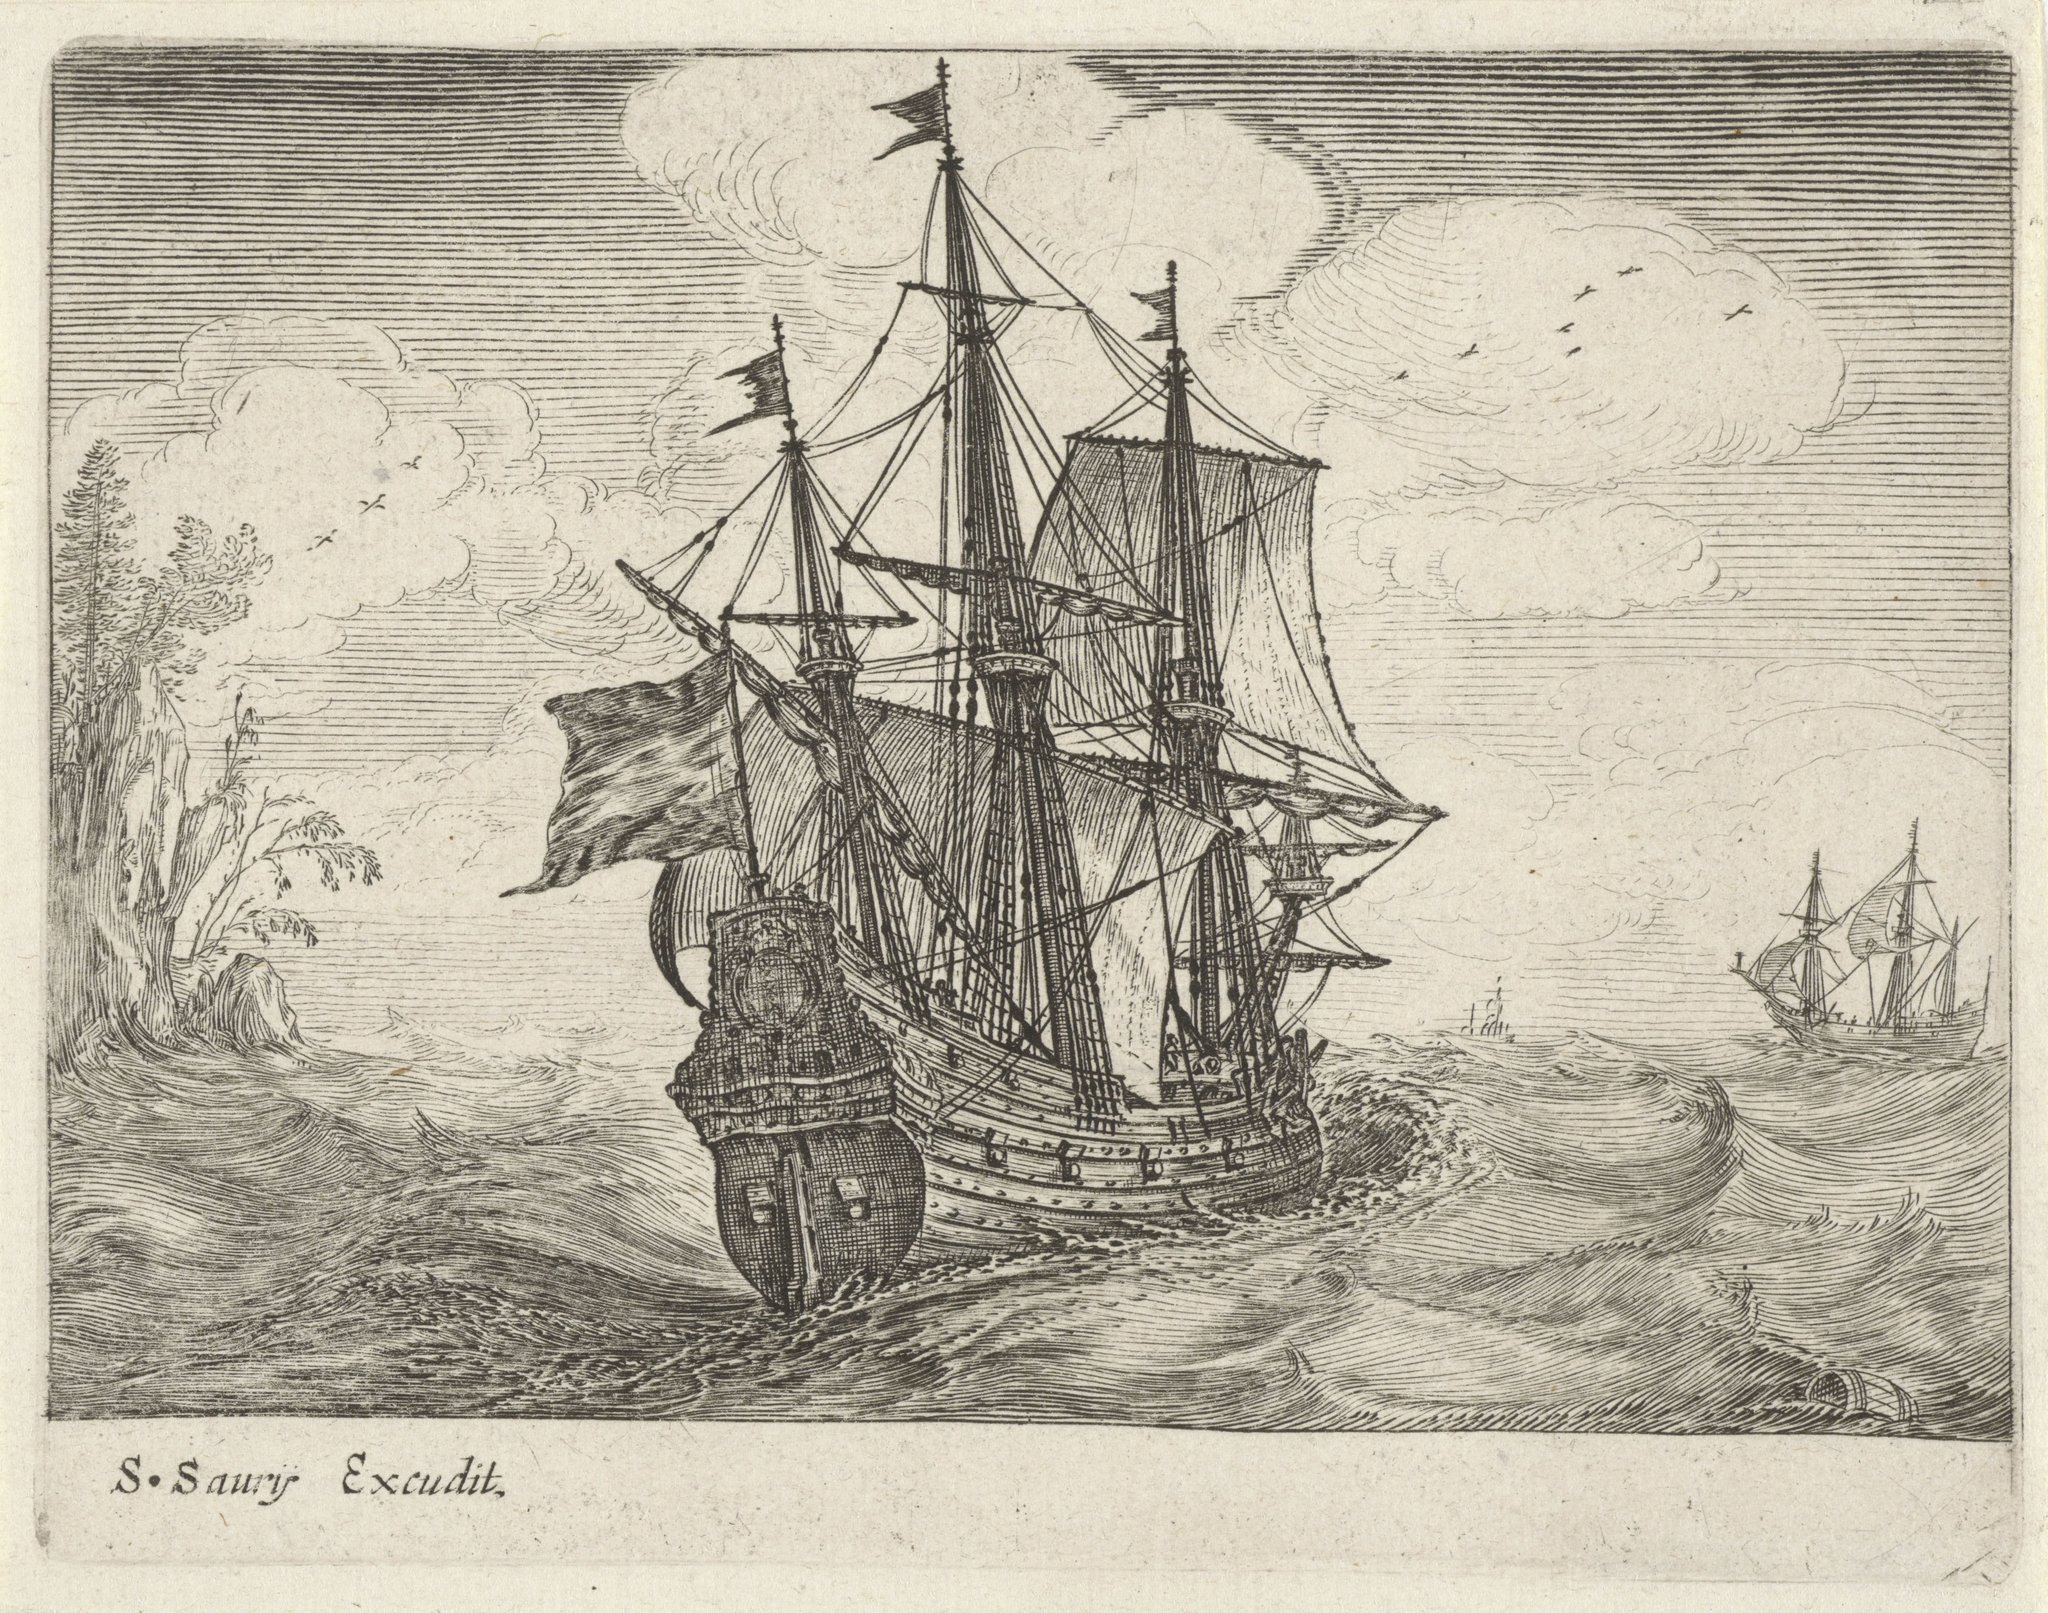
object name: print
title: Zeilschepen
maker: salomon savery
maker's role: print maker, publisher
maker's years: 1594-1683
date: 1610-1665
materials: paper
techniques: engraving, etching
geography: amsterdam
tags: sailing-ship, sailing-boat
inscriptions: collector's mark: Lugt 2228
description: De prent maakt deel uit van een zesdelige serie met voorstellingen van verschillende zeilschepen.